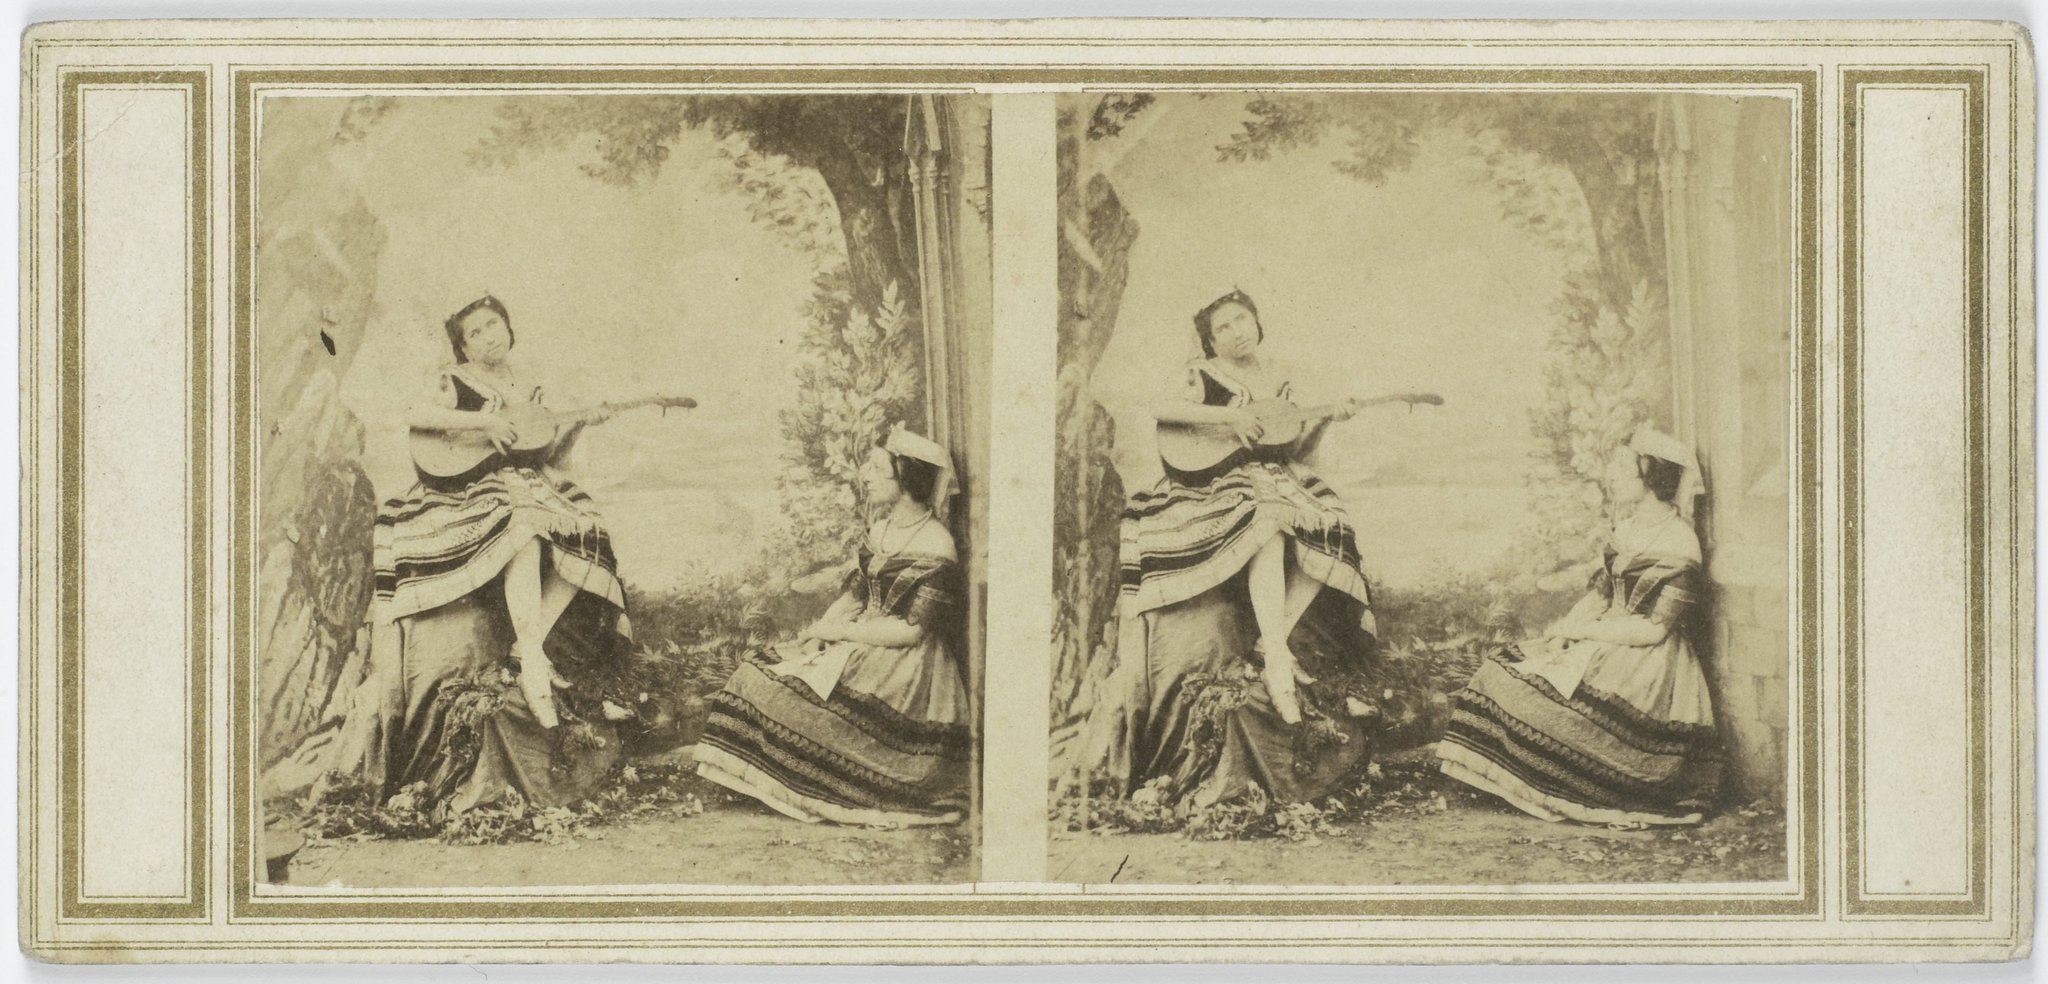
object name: stereograph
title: Vrouw met een gitaar en een andere vrouw die luistert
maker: pierre-ambroise richebourg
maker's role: fotograaf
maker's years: 1810-1875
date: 1850-1880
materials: cardboard, photographic support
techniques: albumen print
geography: europe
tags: 'tableau vivant', cithern, mandolin, guitar, balalaika, europe